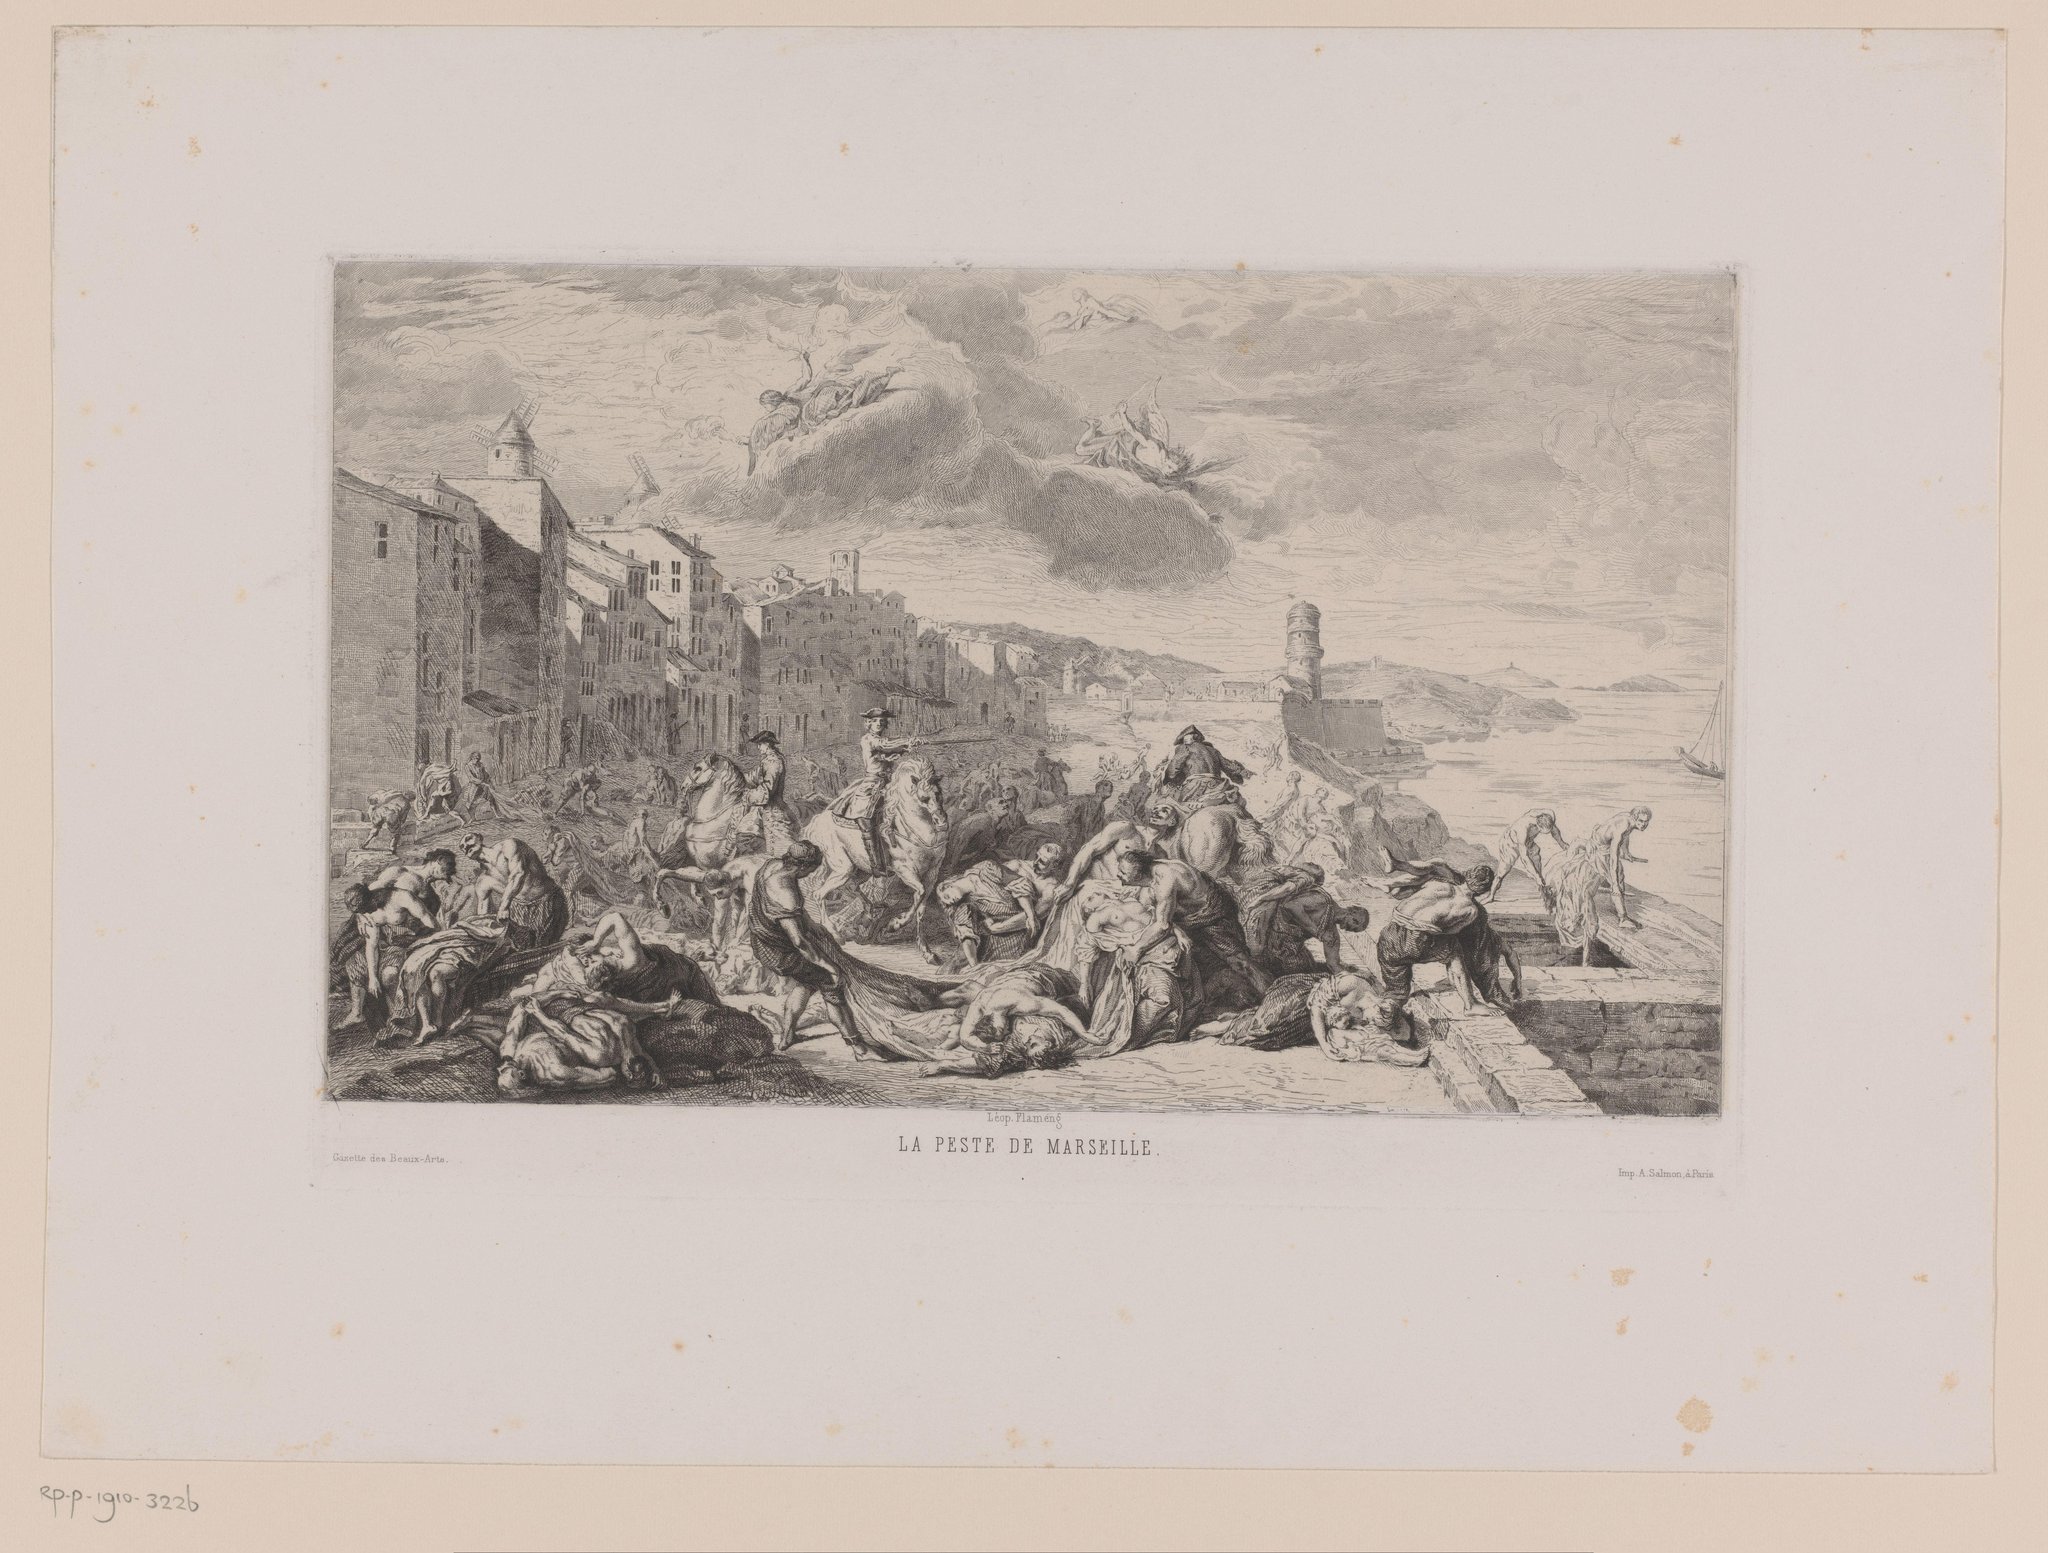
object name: print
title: Slachtoffers van de builenpest worden geruimd in La Tourette, Marseille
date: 1860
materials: paper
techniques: etching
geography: paris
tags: marseille, harbour, slavery; serfs and enslaved persons, quay, plague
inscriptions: collector's mark: Lugt 2228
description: In de wijk La Tourette worden de lichamen van de pestslachtoffers onder leiding van Nicolas Roze (Chevalier Roze) geruimd door galeiroeiers en soldaten. Op de galeien werd voornamelijk gebruik gemaakt van onvrije arbeidskrachten. Veel van de roeiers waren islamitische galeislaven, die als dusdanig te herkennen zijn door hun enkelboeien en het typerende kapsel (hoofd op een pluk na kaalgeschoren) dat zij verplicht waren te hebben. Hiermee waren ze te onderscheiden van bijvoorbeeld politieke gevangenen die tot de galeien veroordeeld waren. De galeiroeiers die hielpen bij het ruimen van de pestslachtoffers in Marseille was in ruil daarvoor vrijheid beloofd, maar het merendeel van hen bezweek zelf aan de ziekte.